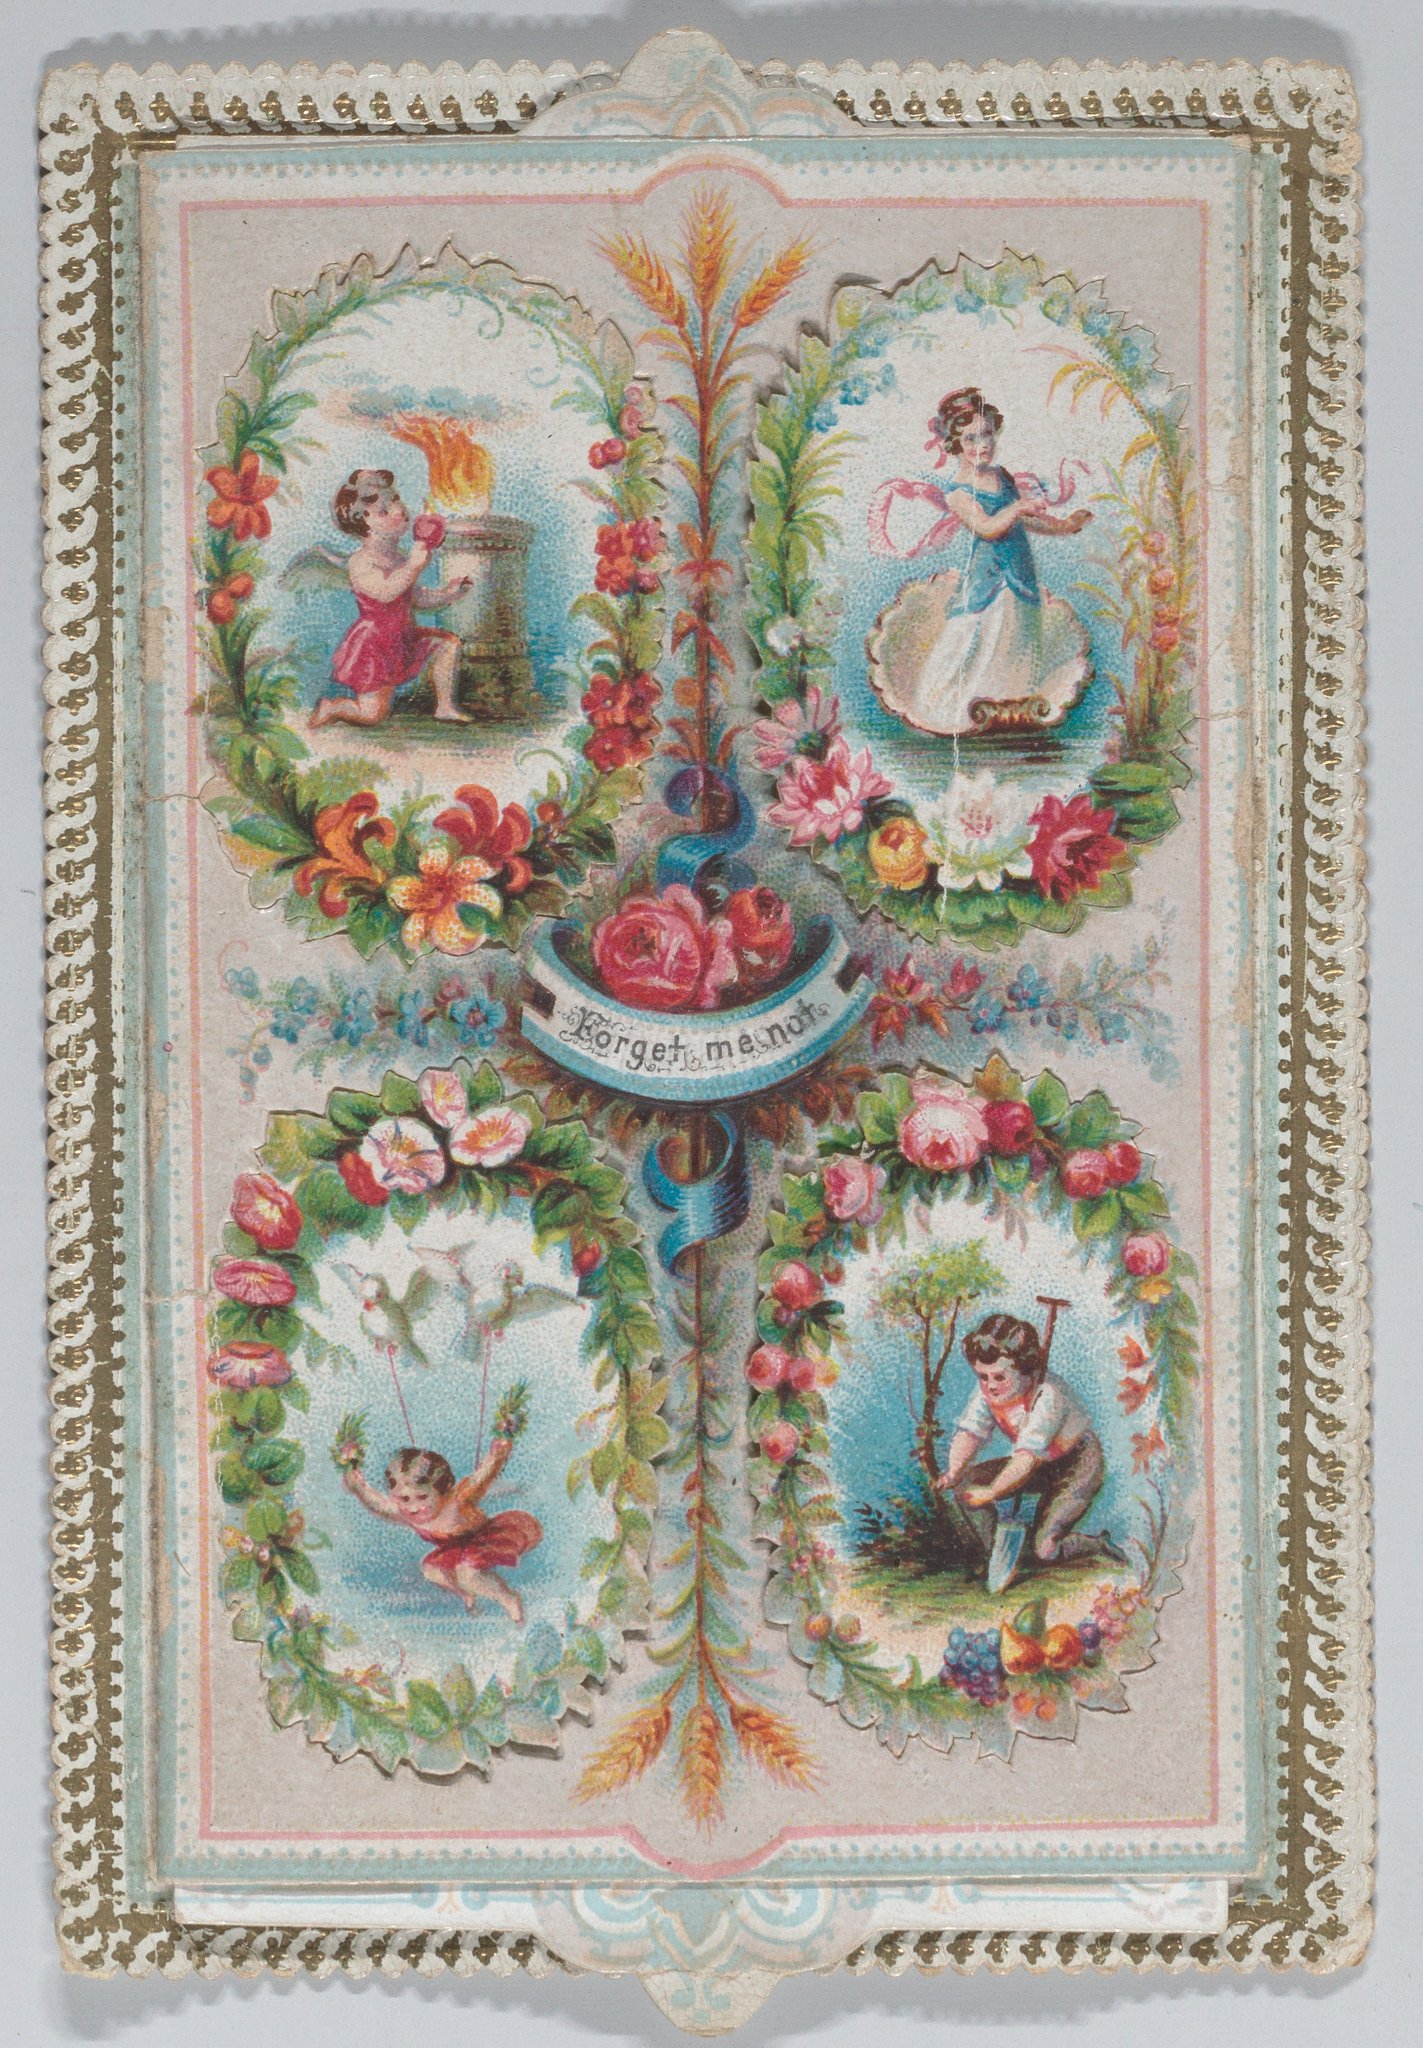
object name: valentine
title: Valentine - Mechanical, four ovals, flaps, images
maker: anonymous, german, 19th century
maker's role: artist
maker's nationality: german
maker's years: 1800-1899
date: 1875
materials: ink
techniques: chromolithography, cutting, gilding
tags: boys,girls,cupid,flowers